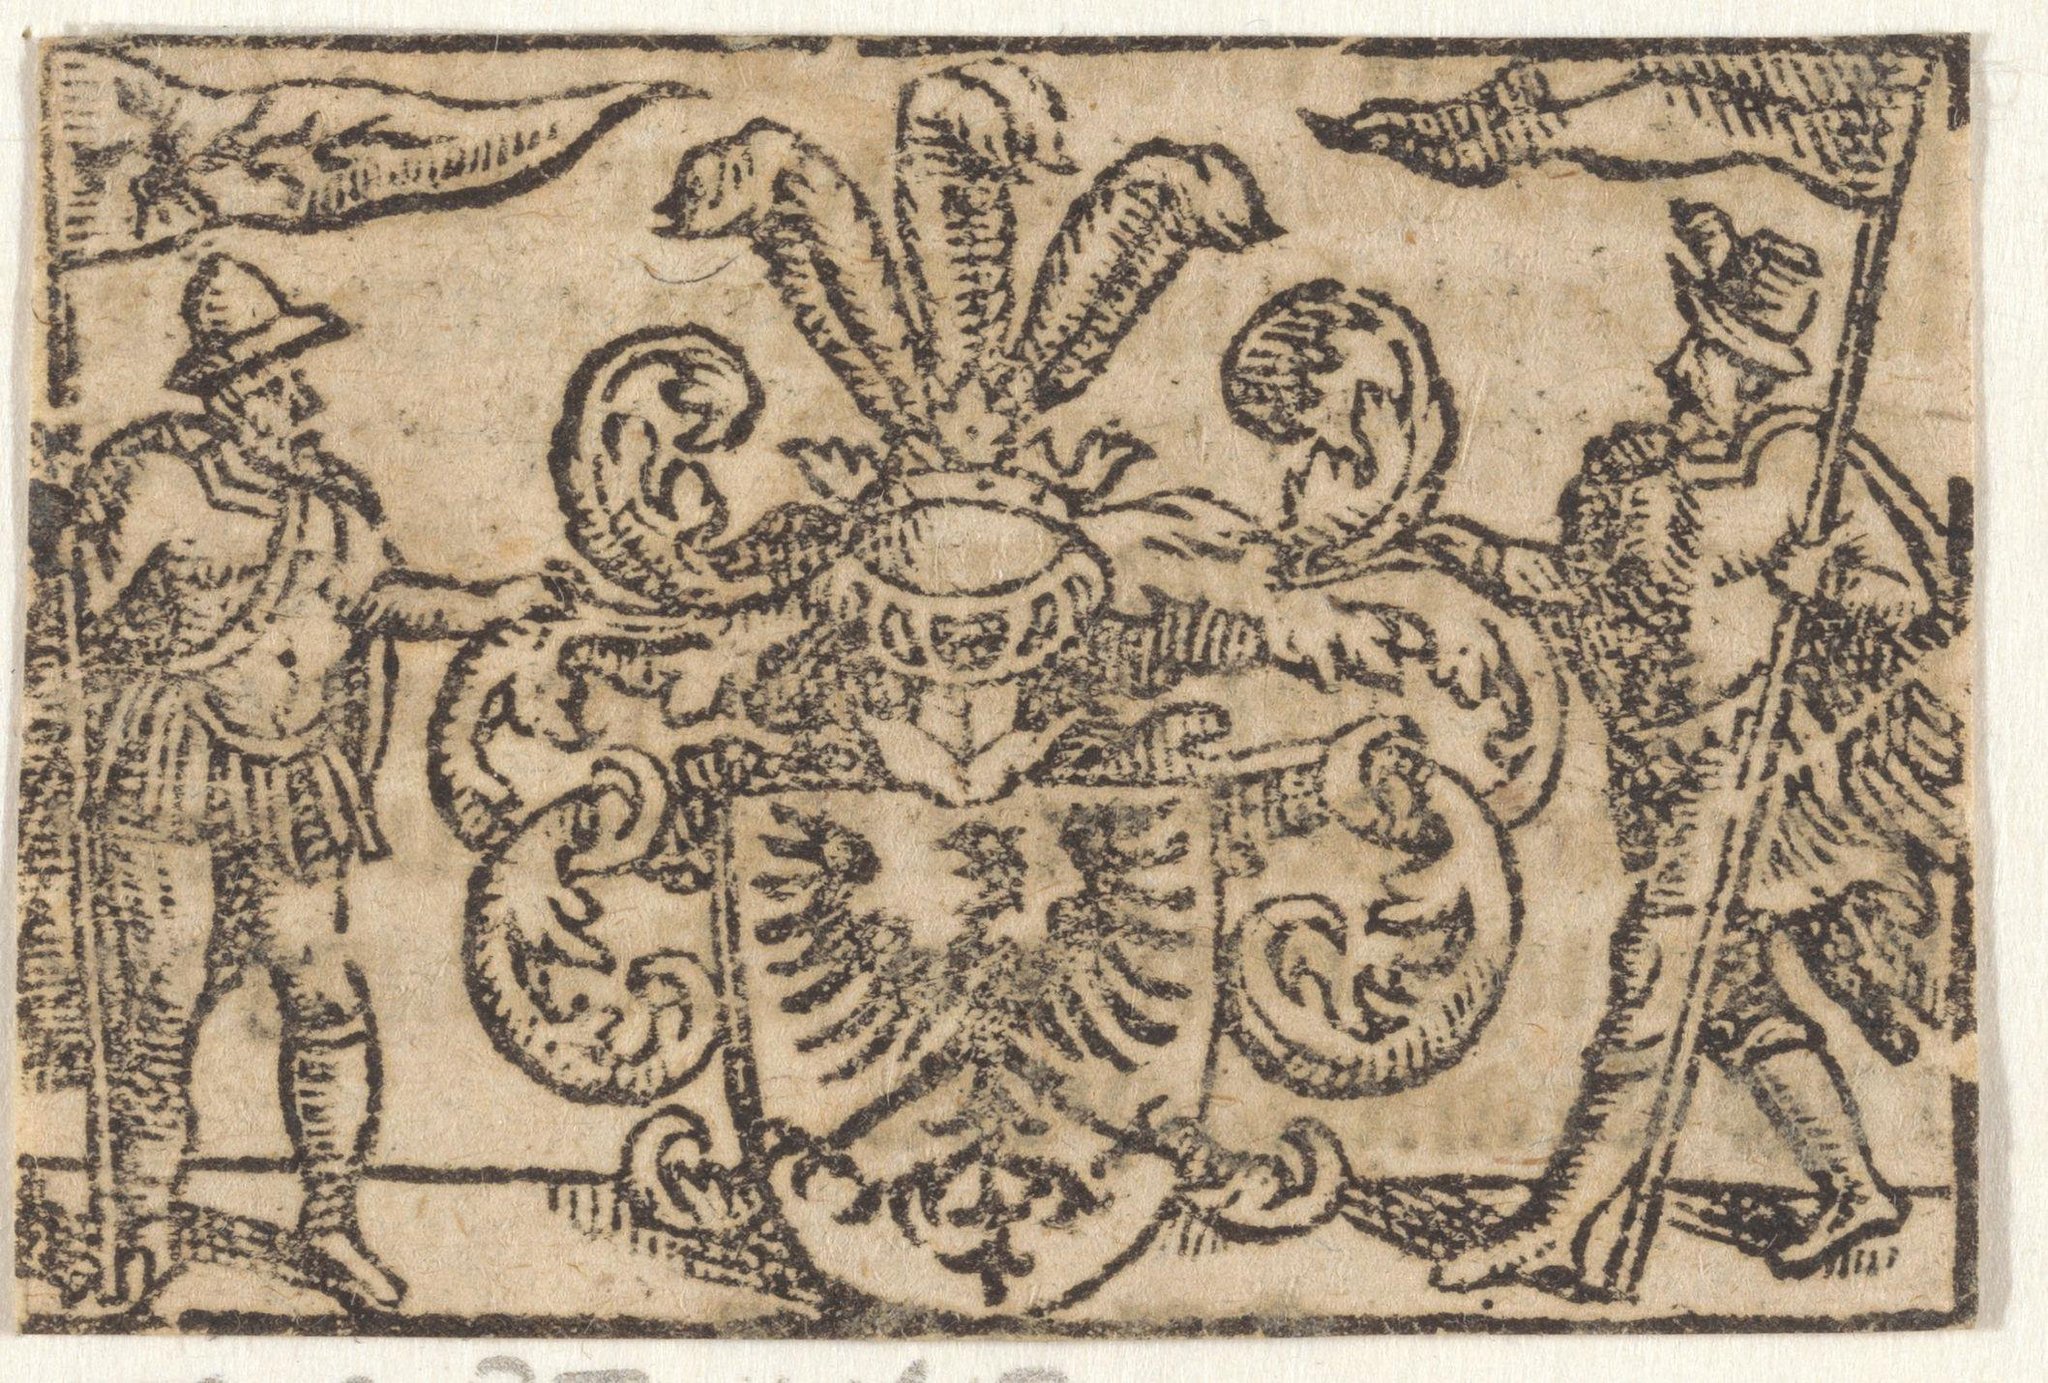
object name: print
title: Twee vaandeldragers en een wapen met daarop een zwarte adelaar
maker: Anonymous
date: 1600-1699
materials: paper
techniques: letterpress printing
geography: netherlands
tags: coat of arms (as symbol of the state, etc.), standard-bearer, flag-bearer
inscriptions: collector's mark: Lugt 240